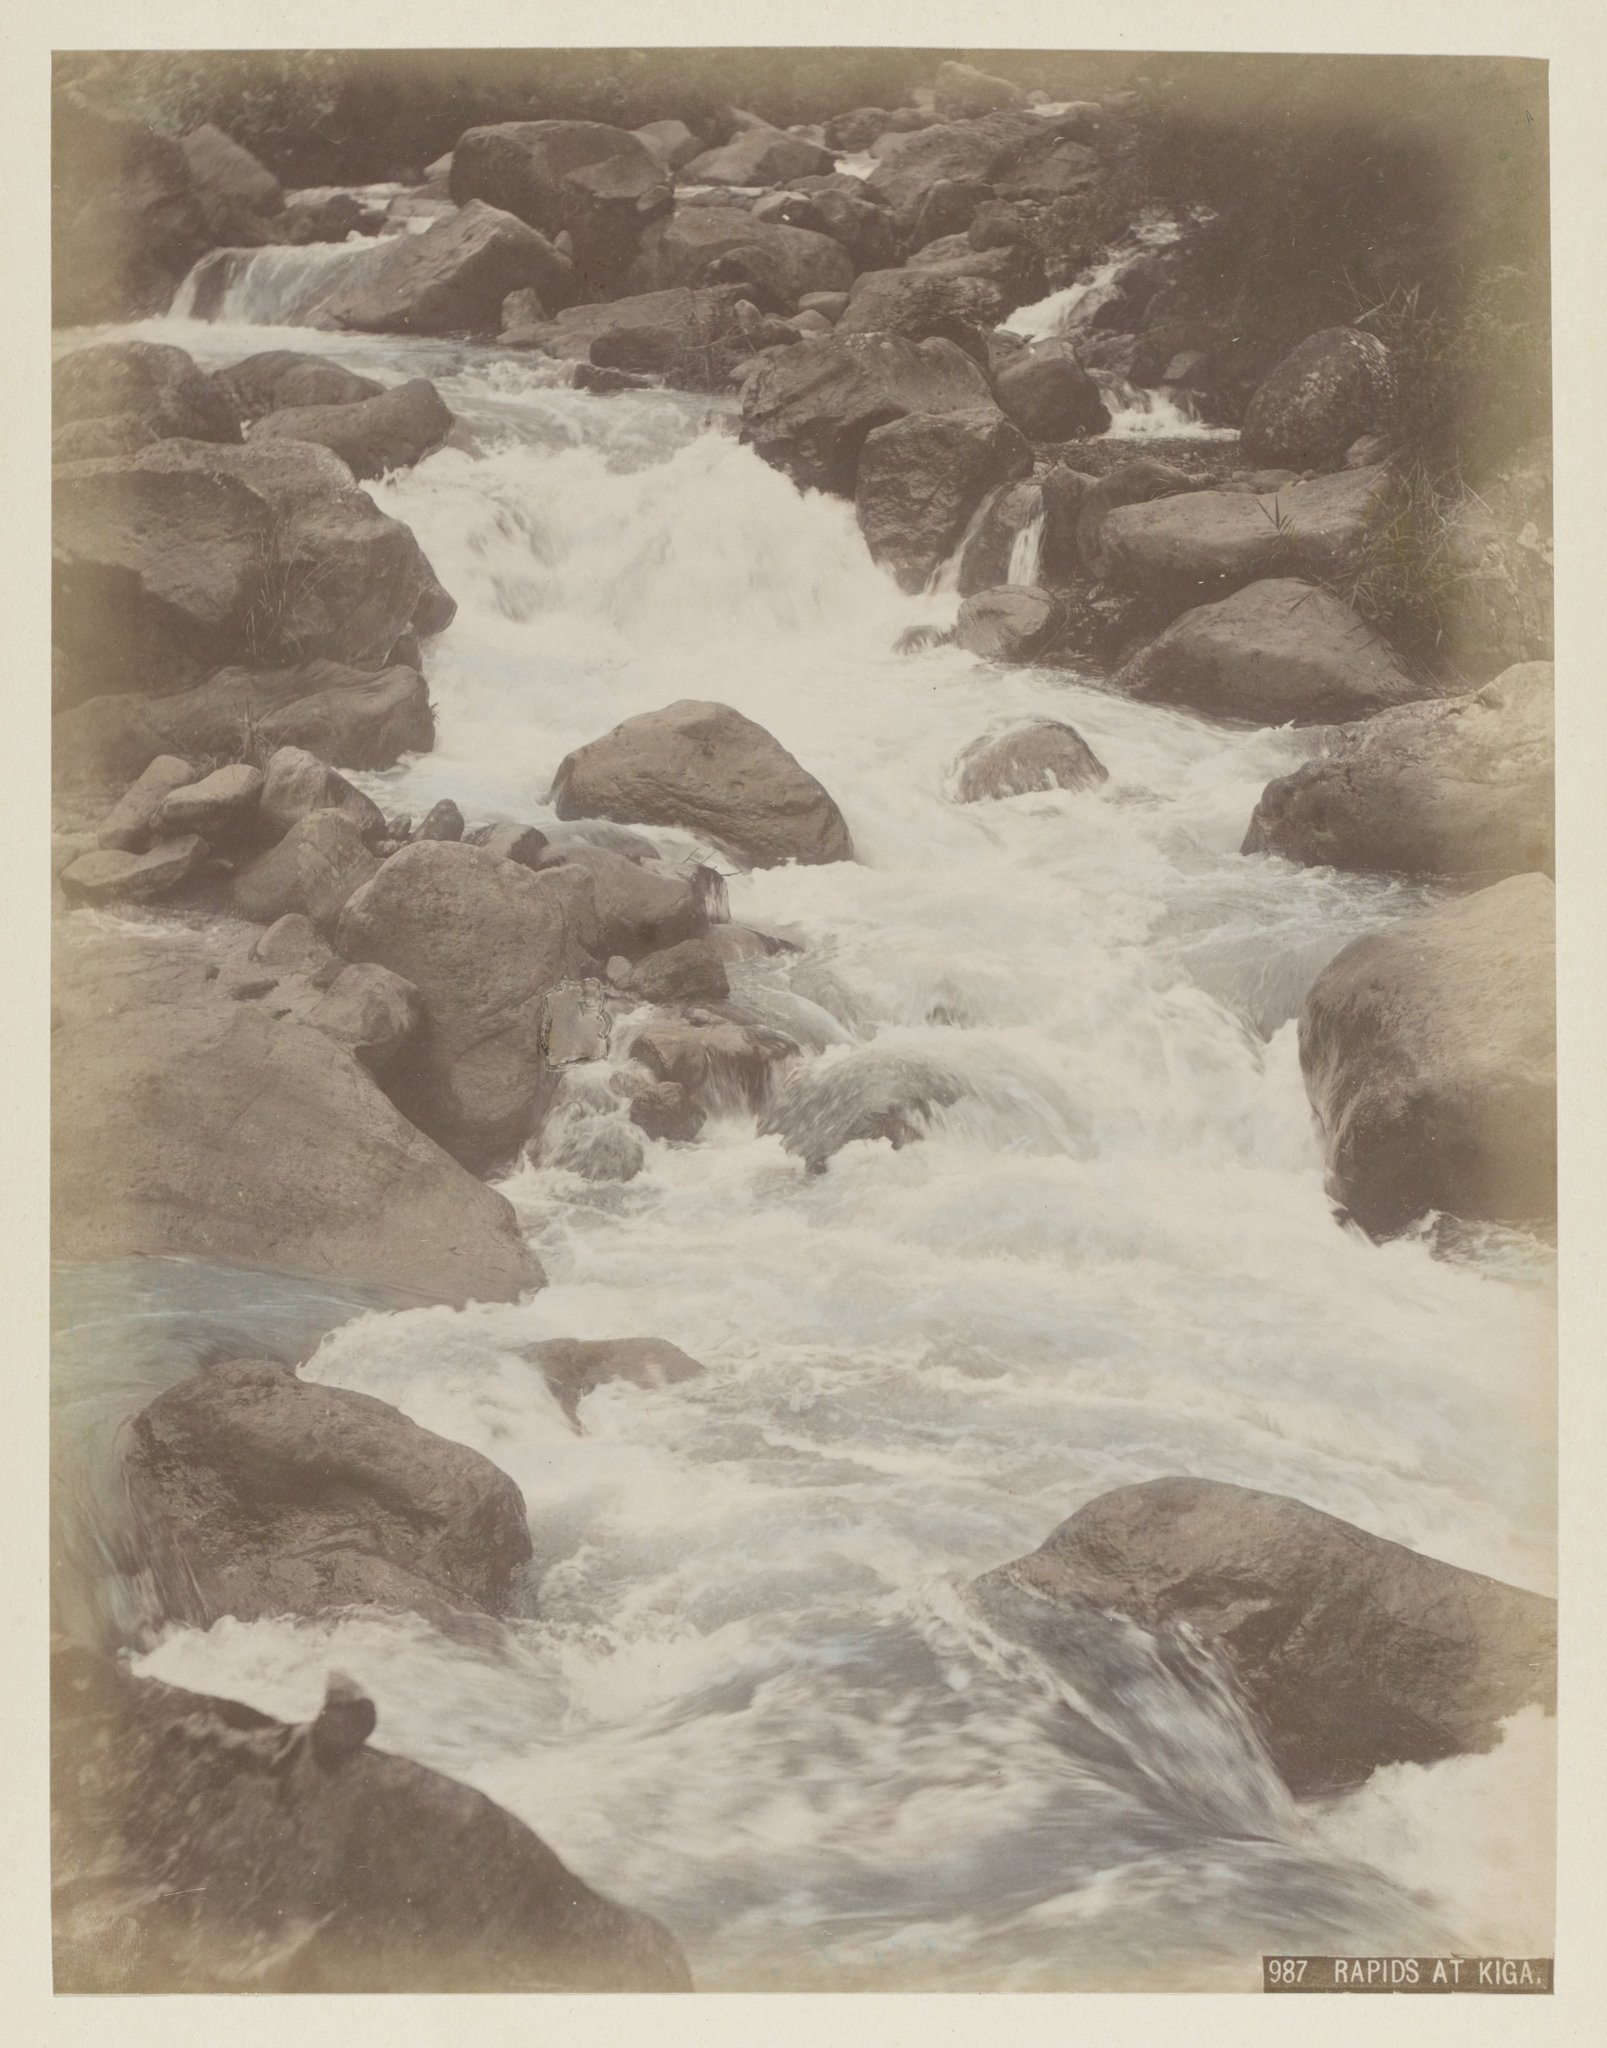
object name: photograph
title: Rapids at Kiga.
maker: Anonymous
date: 1870-1900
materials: paper, photographic support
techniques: albumen print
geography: kiga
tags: rapids, brook, travelling; tourism, boulder, stone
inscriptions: negative number: ‘987’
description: Onderdeel van Fotoalbum met 50 foto's van bezienswaardigheden in Japan.